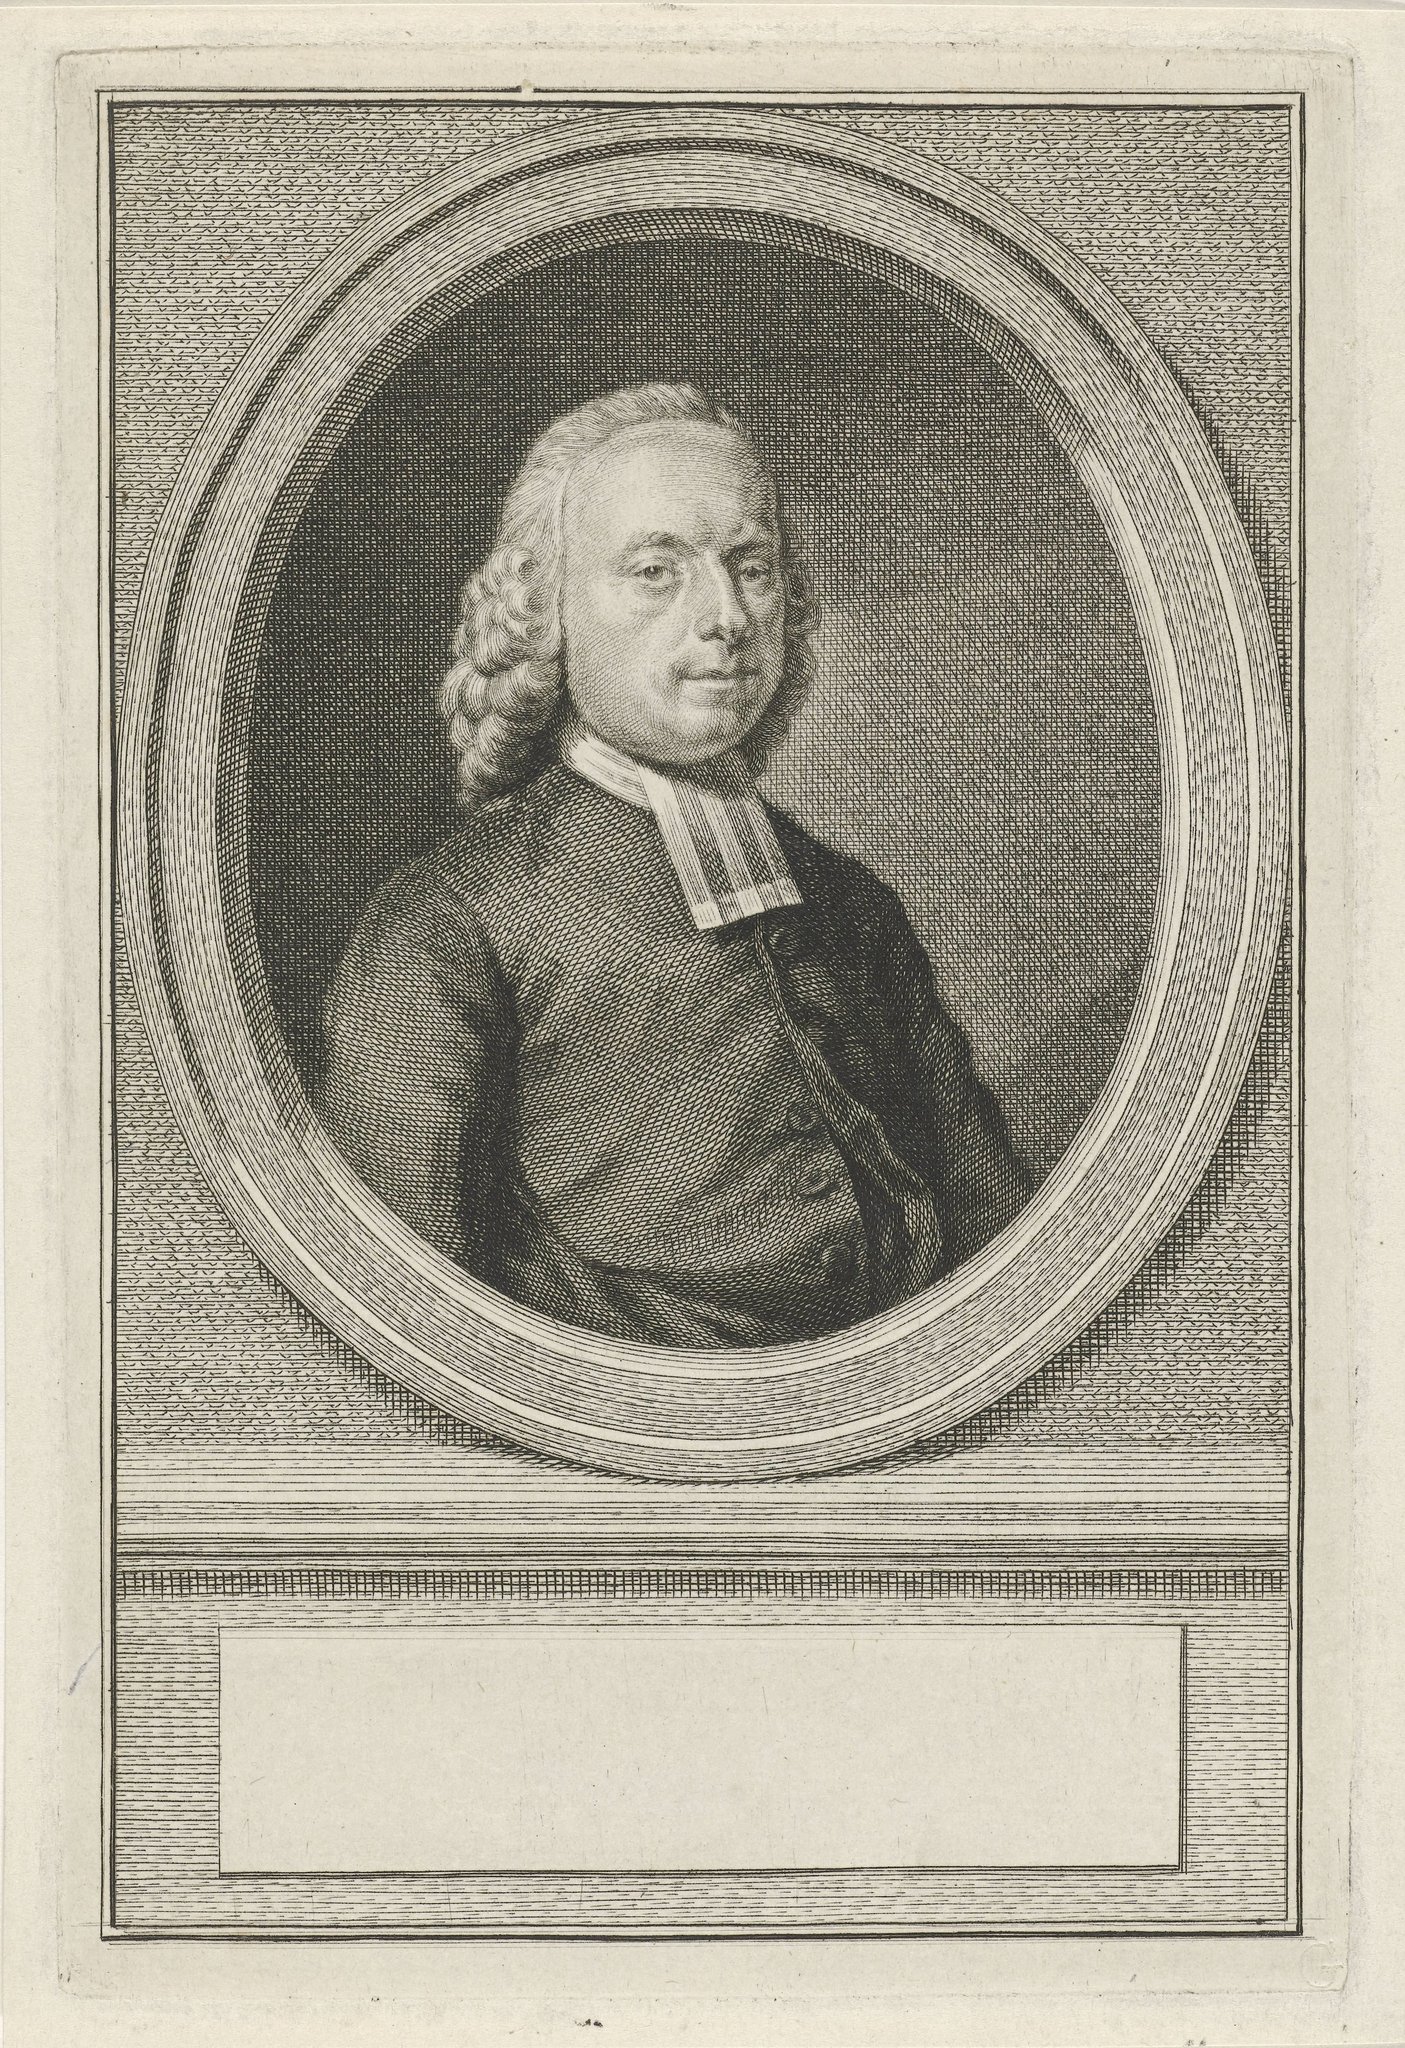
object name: print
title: Portret van Dirk Seimens van Binnevest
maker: jacob houbraken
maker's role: draughtsman, print maker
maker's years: 1698-1780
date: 1774-1776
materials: paper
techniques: engraving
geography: amsterdam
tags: dirk seimens van binnevest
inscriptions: collector's mark: Lugt 2228, collector's mark: Lugt 1120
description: Proefdruk van de prent volgens Ver Huell gebruikt in: Josua van Iperen, Kerkelyke historie van het psalm-gezang der christenen (...) en inzonderheid van onze verbeterde Nederduitsche psalmberyminge. Amsterdam: wed. Loveringh en Allart, 1777. Deel 2: J. Allart, 1778.